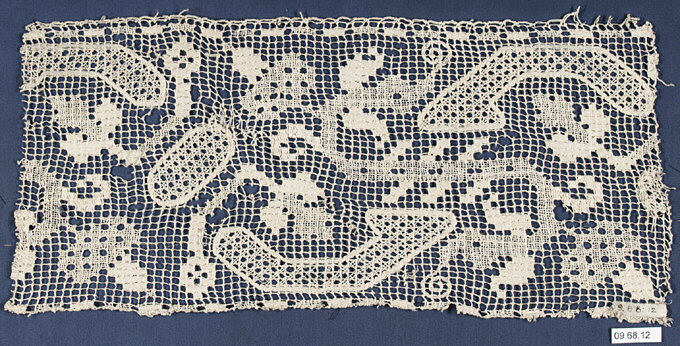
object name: fragment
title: Fragment or piece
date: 1501-1700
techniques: embroidery